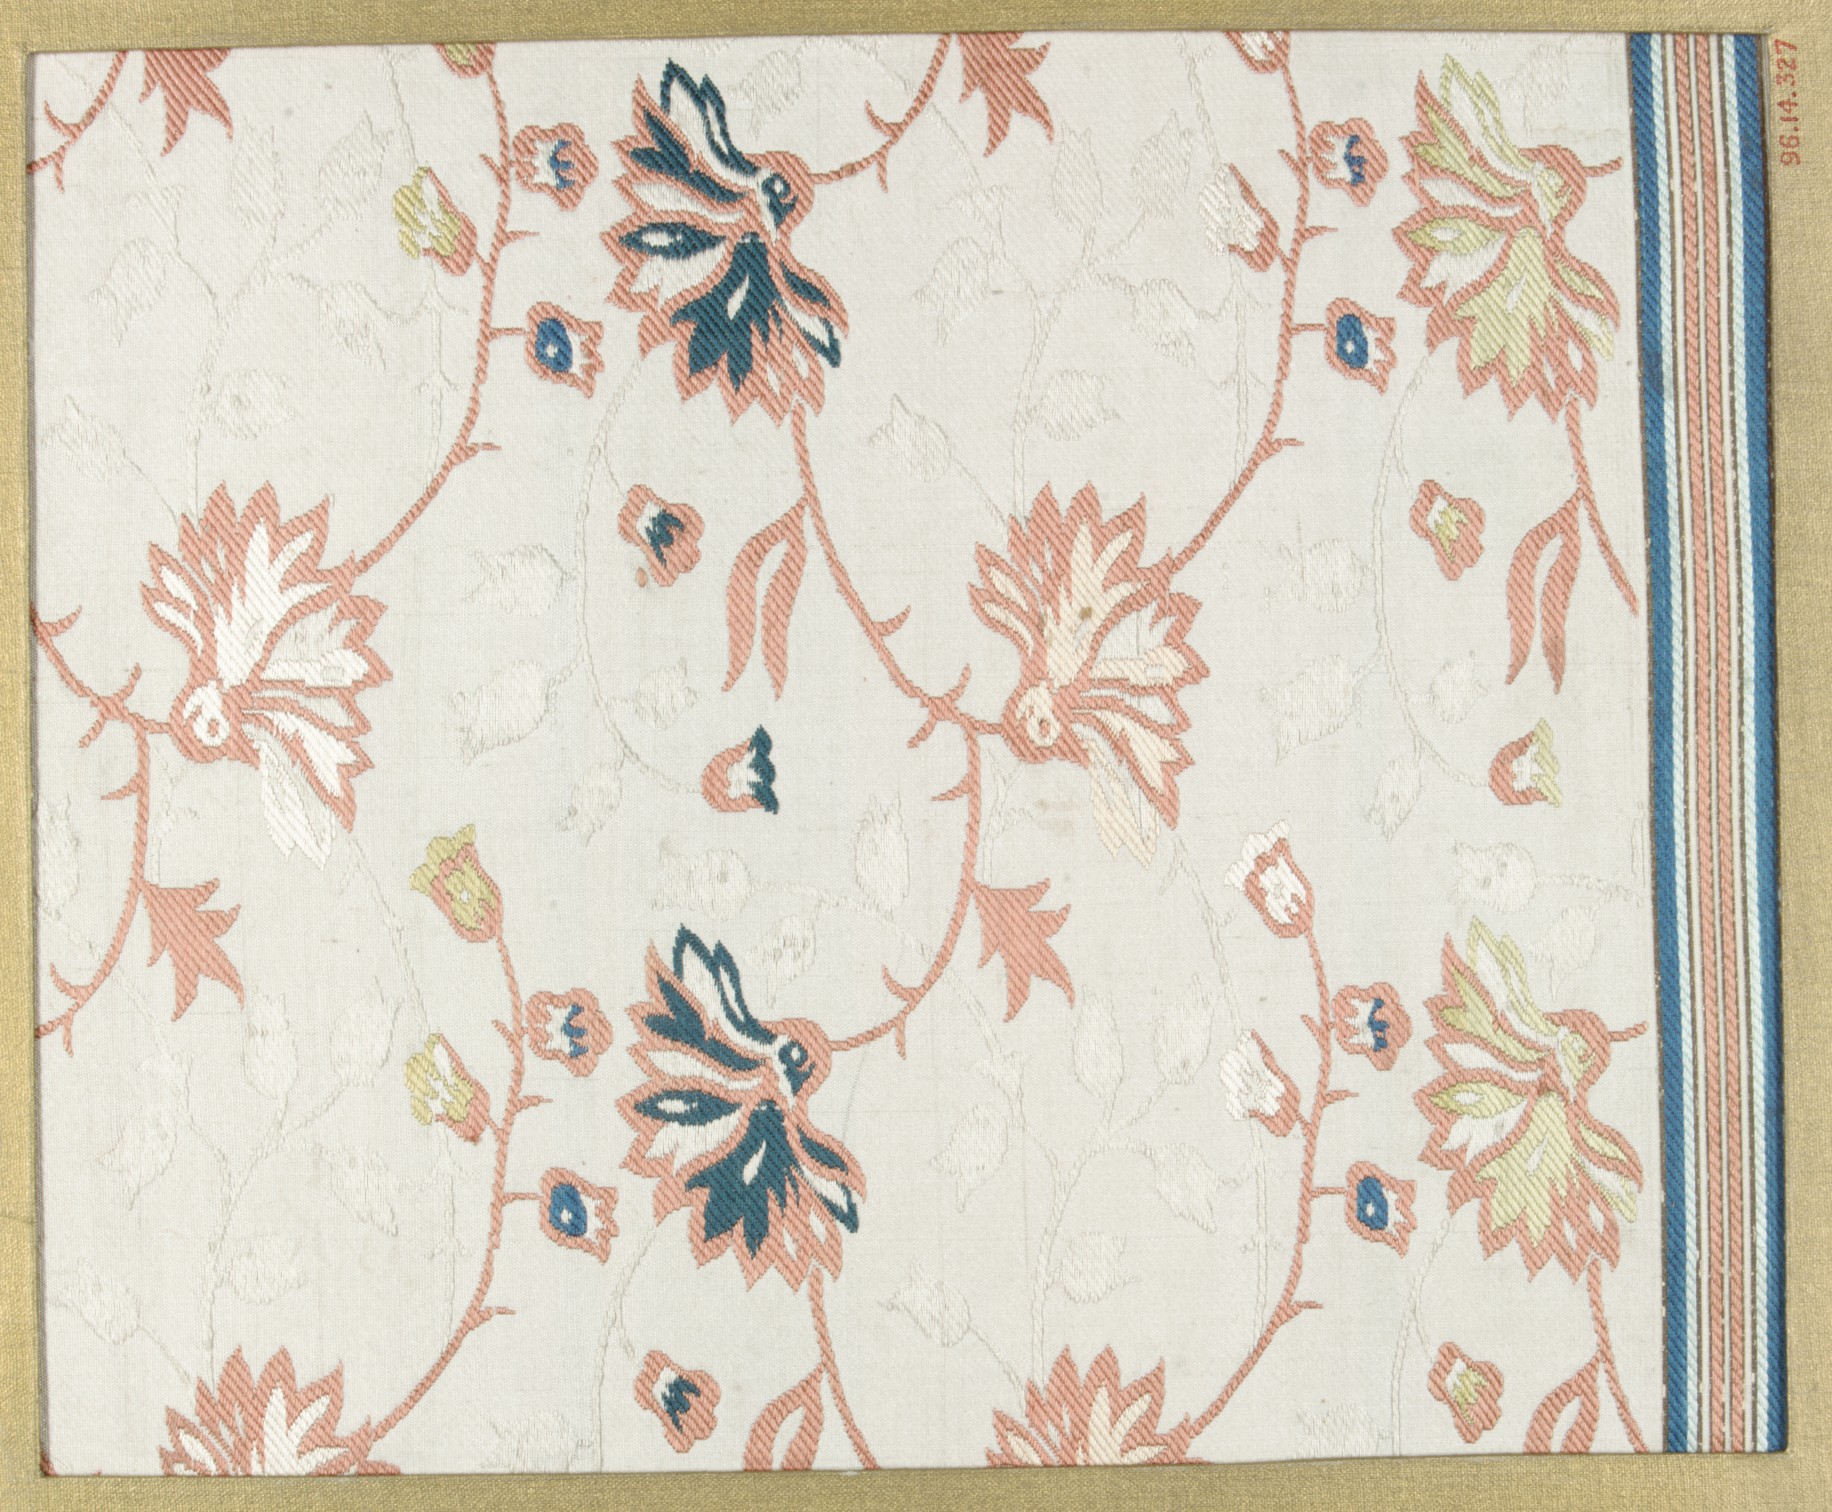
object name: piece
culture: japanese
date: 1701-1900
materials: silk